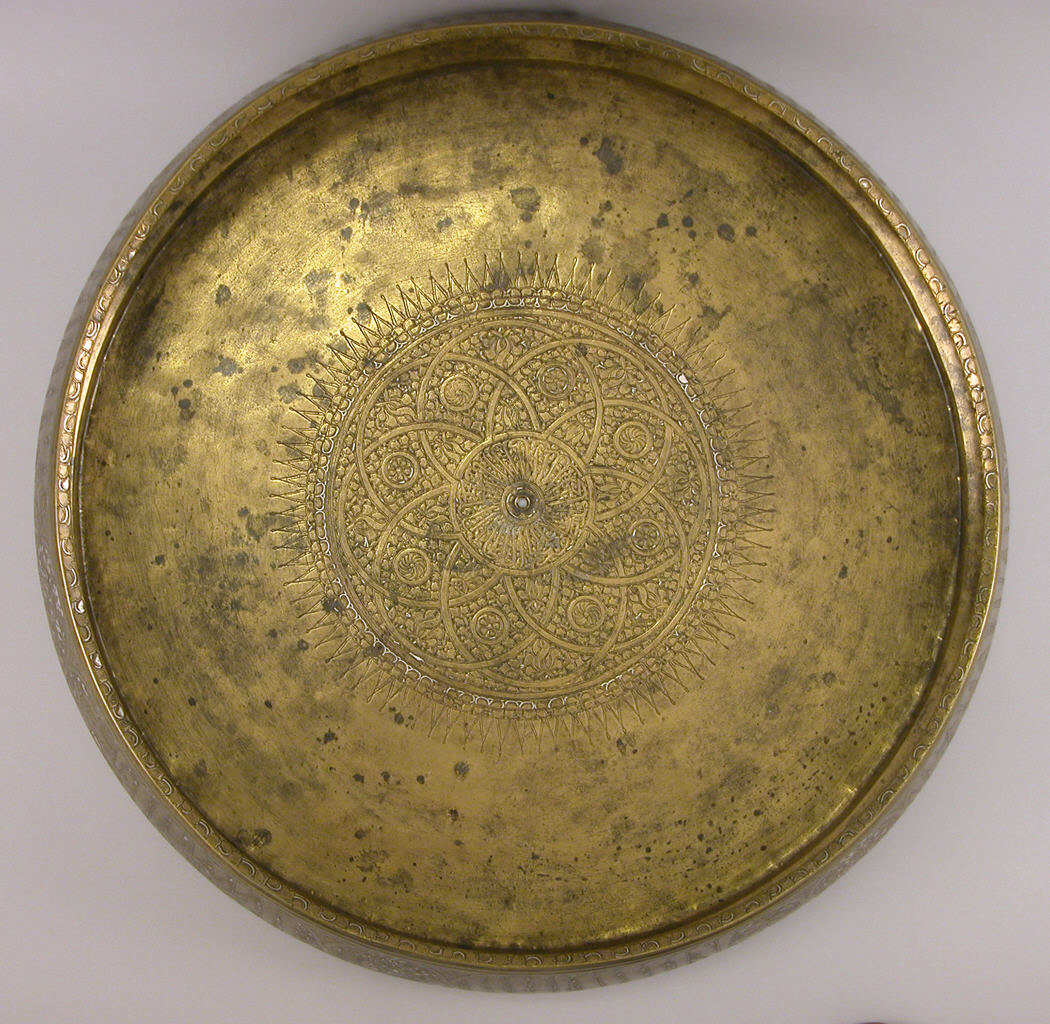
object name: basin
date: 1301-1333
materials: brass, silver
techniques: inlay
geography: egypt